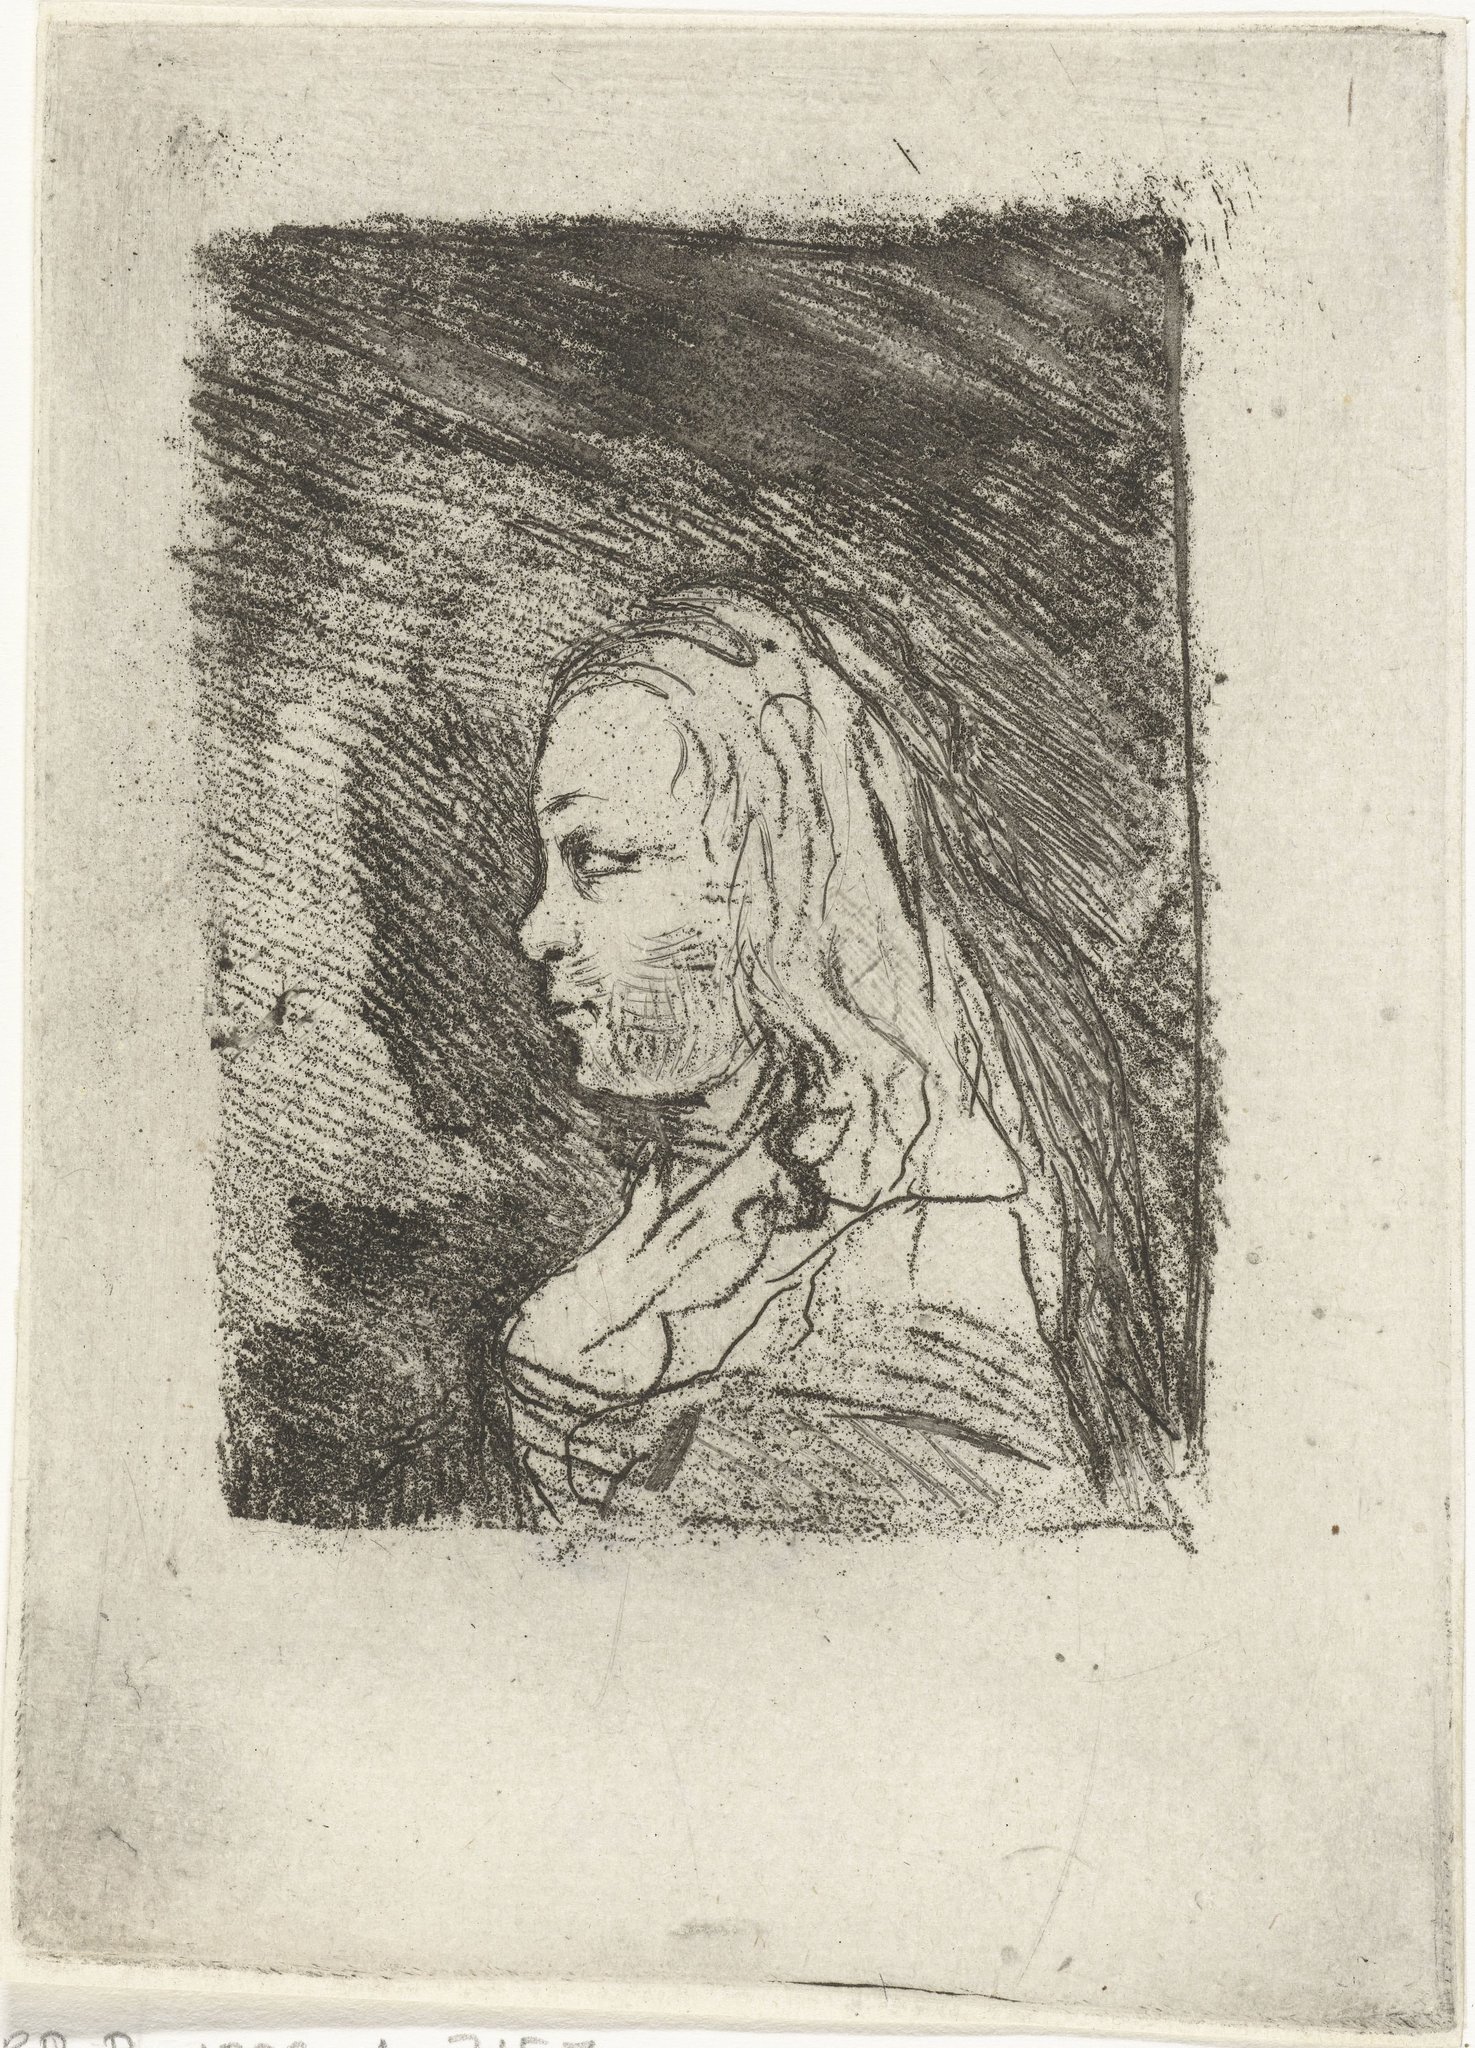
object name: print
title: Borstbeeld van eene jonge vrouw in profiel naar links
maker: louis bernard coclers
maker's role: draughtsman, print maker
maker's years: 1741-1817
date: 1756-1817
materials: paper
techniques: printmaking, etching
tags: adolescent, young woman, maiden (+ front view)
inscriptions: collector's mark: Lugt 2228